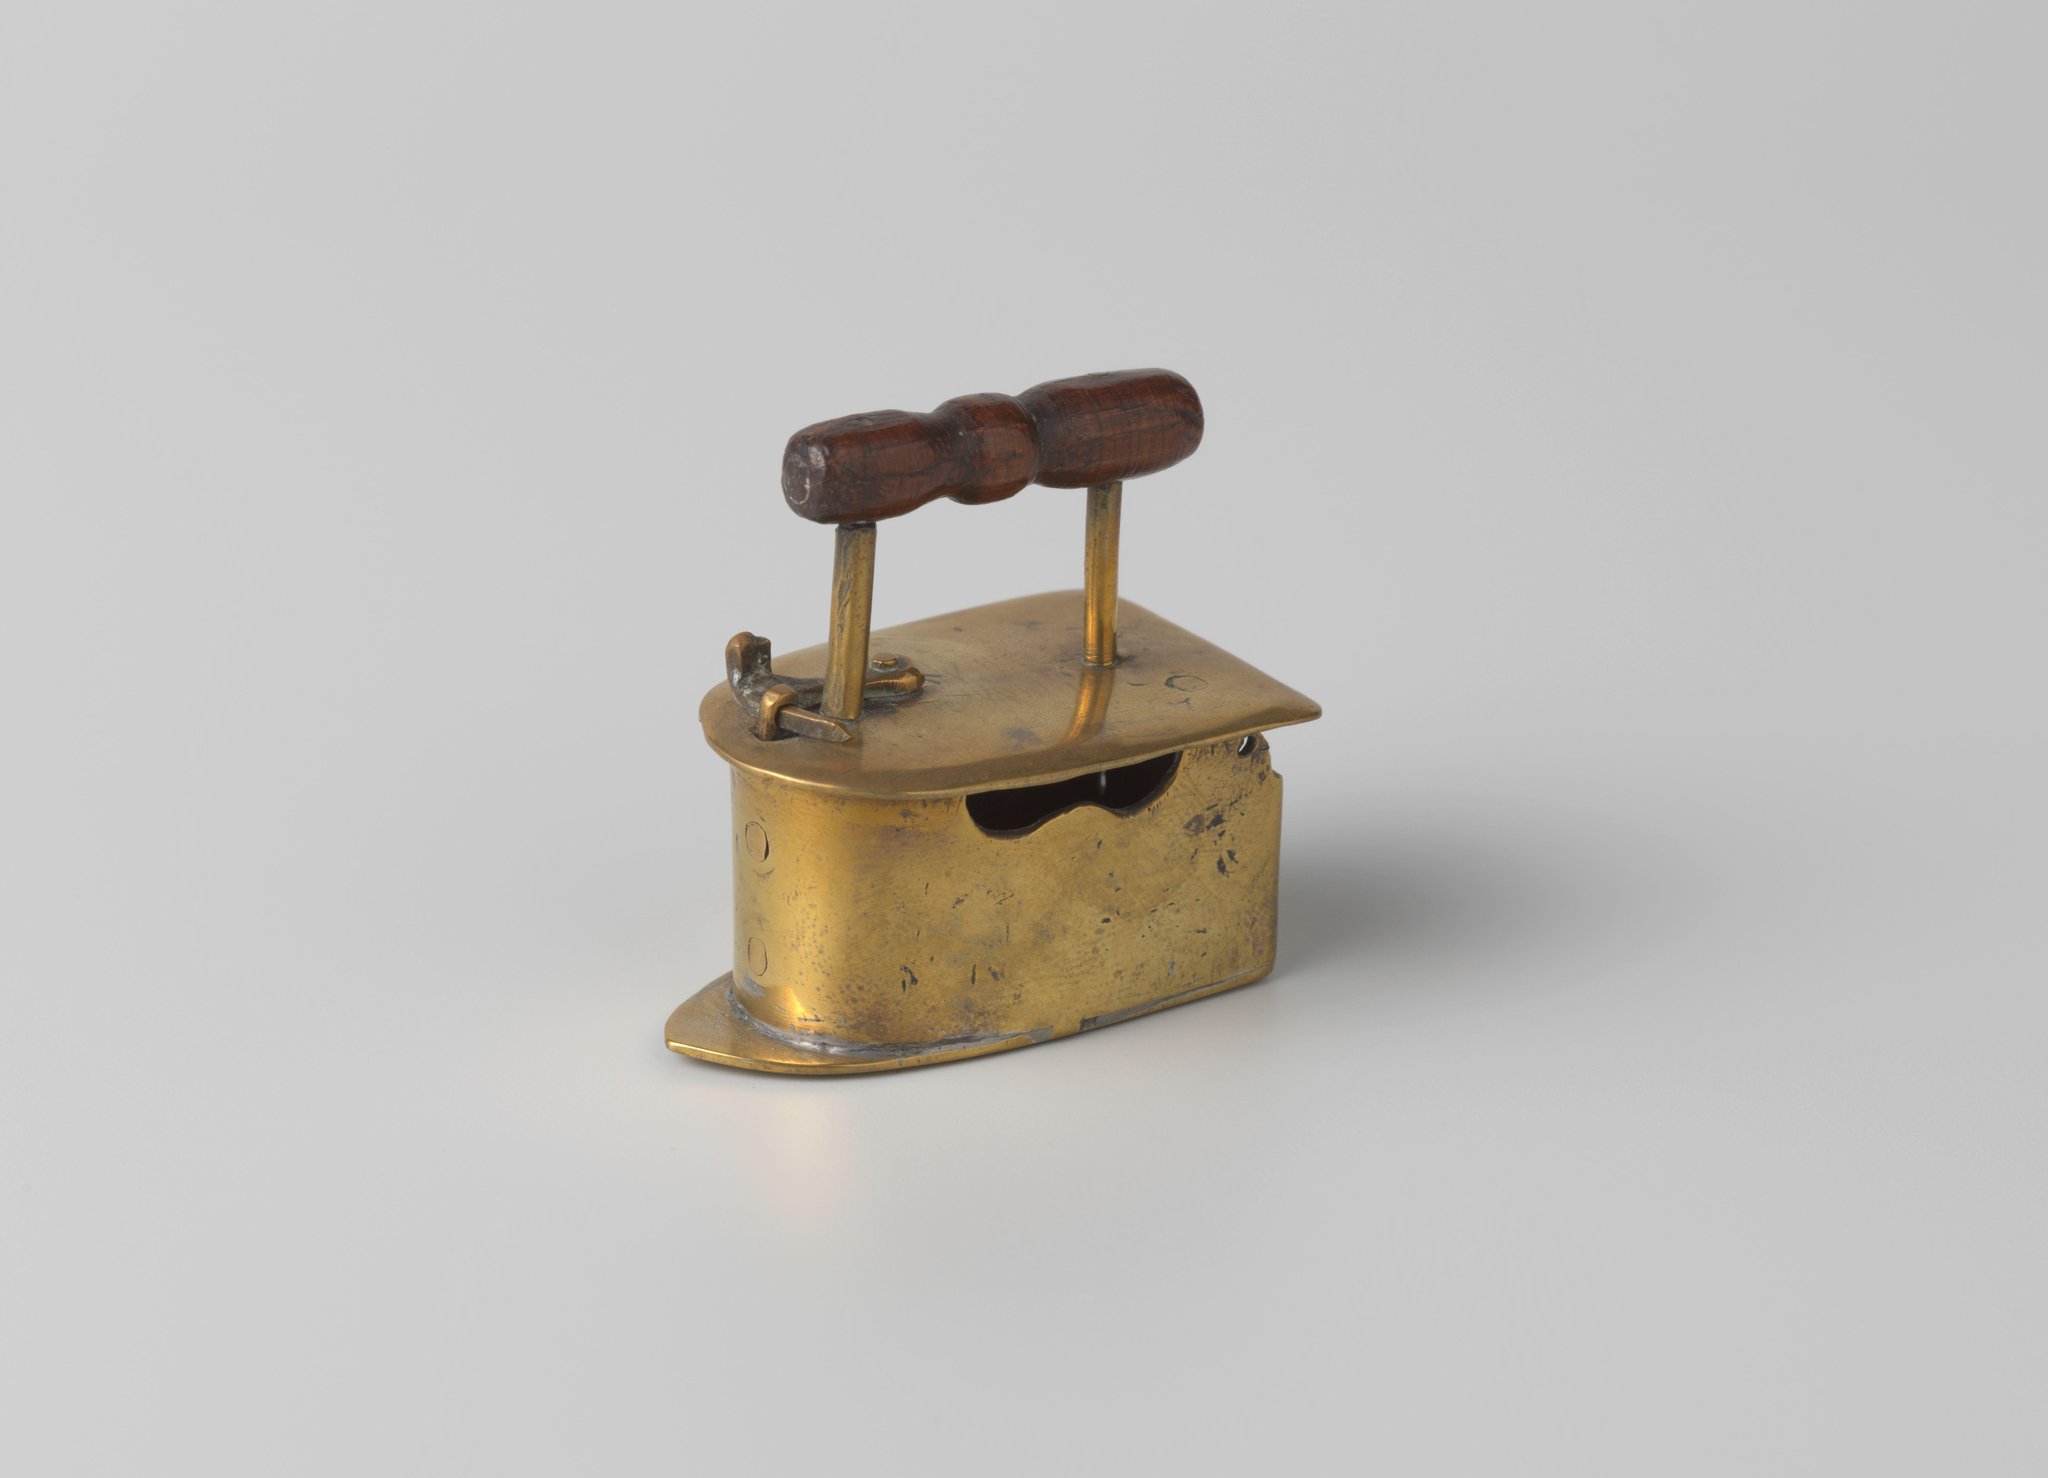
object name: iron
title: Strijkijzer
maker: Anonymous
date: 1700-1800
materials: brass, wood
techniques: cutting, striking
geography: netherlands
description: Het uit plaat gemaakte voorwerpheeft een wand,die op drieplaatsen is uitgesneden. Het deksel kan worden opgeklapt en met een haak worden vastgezet.